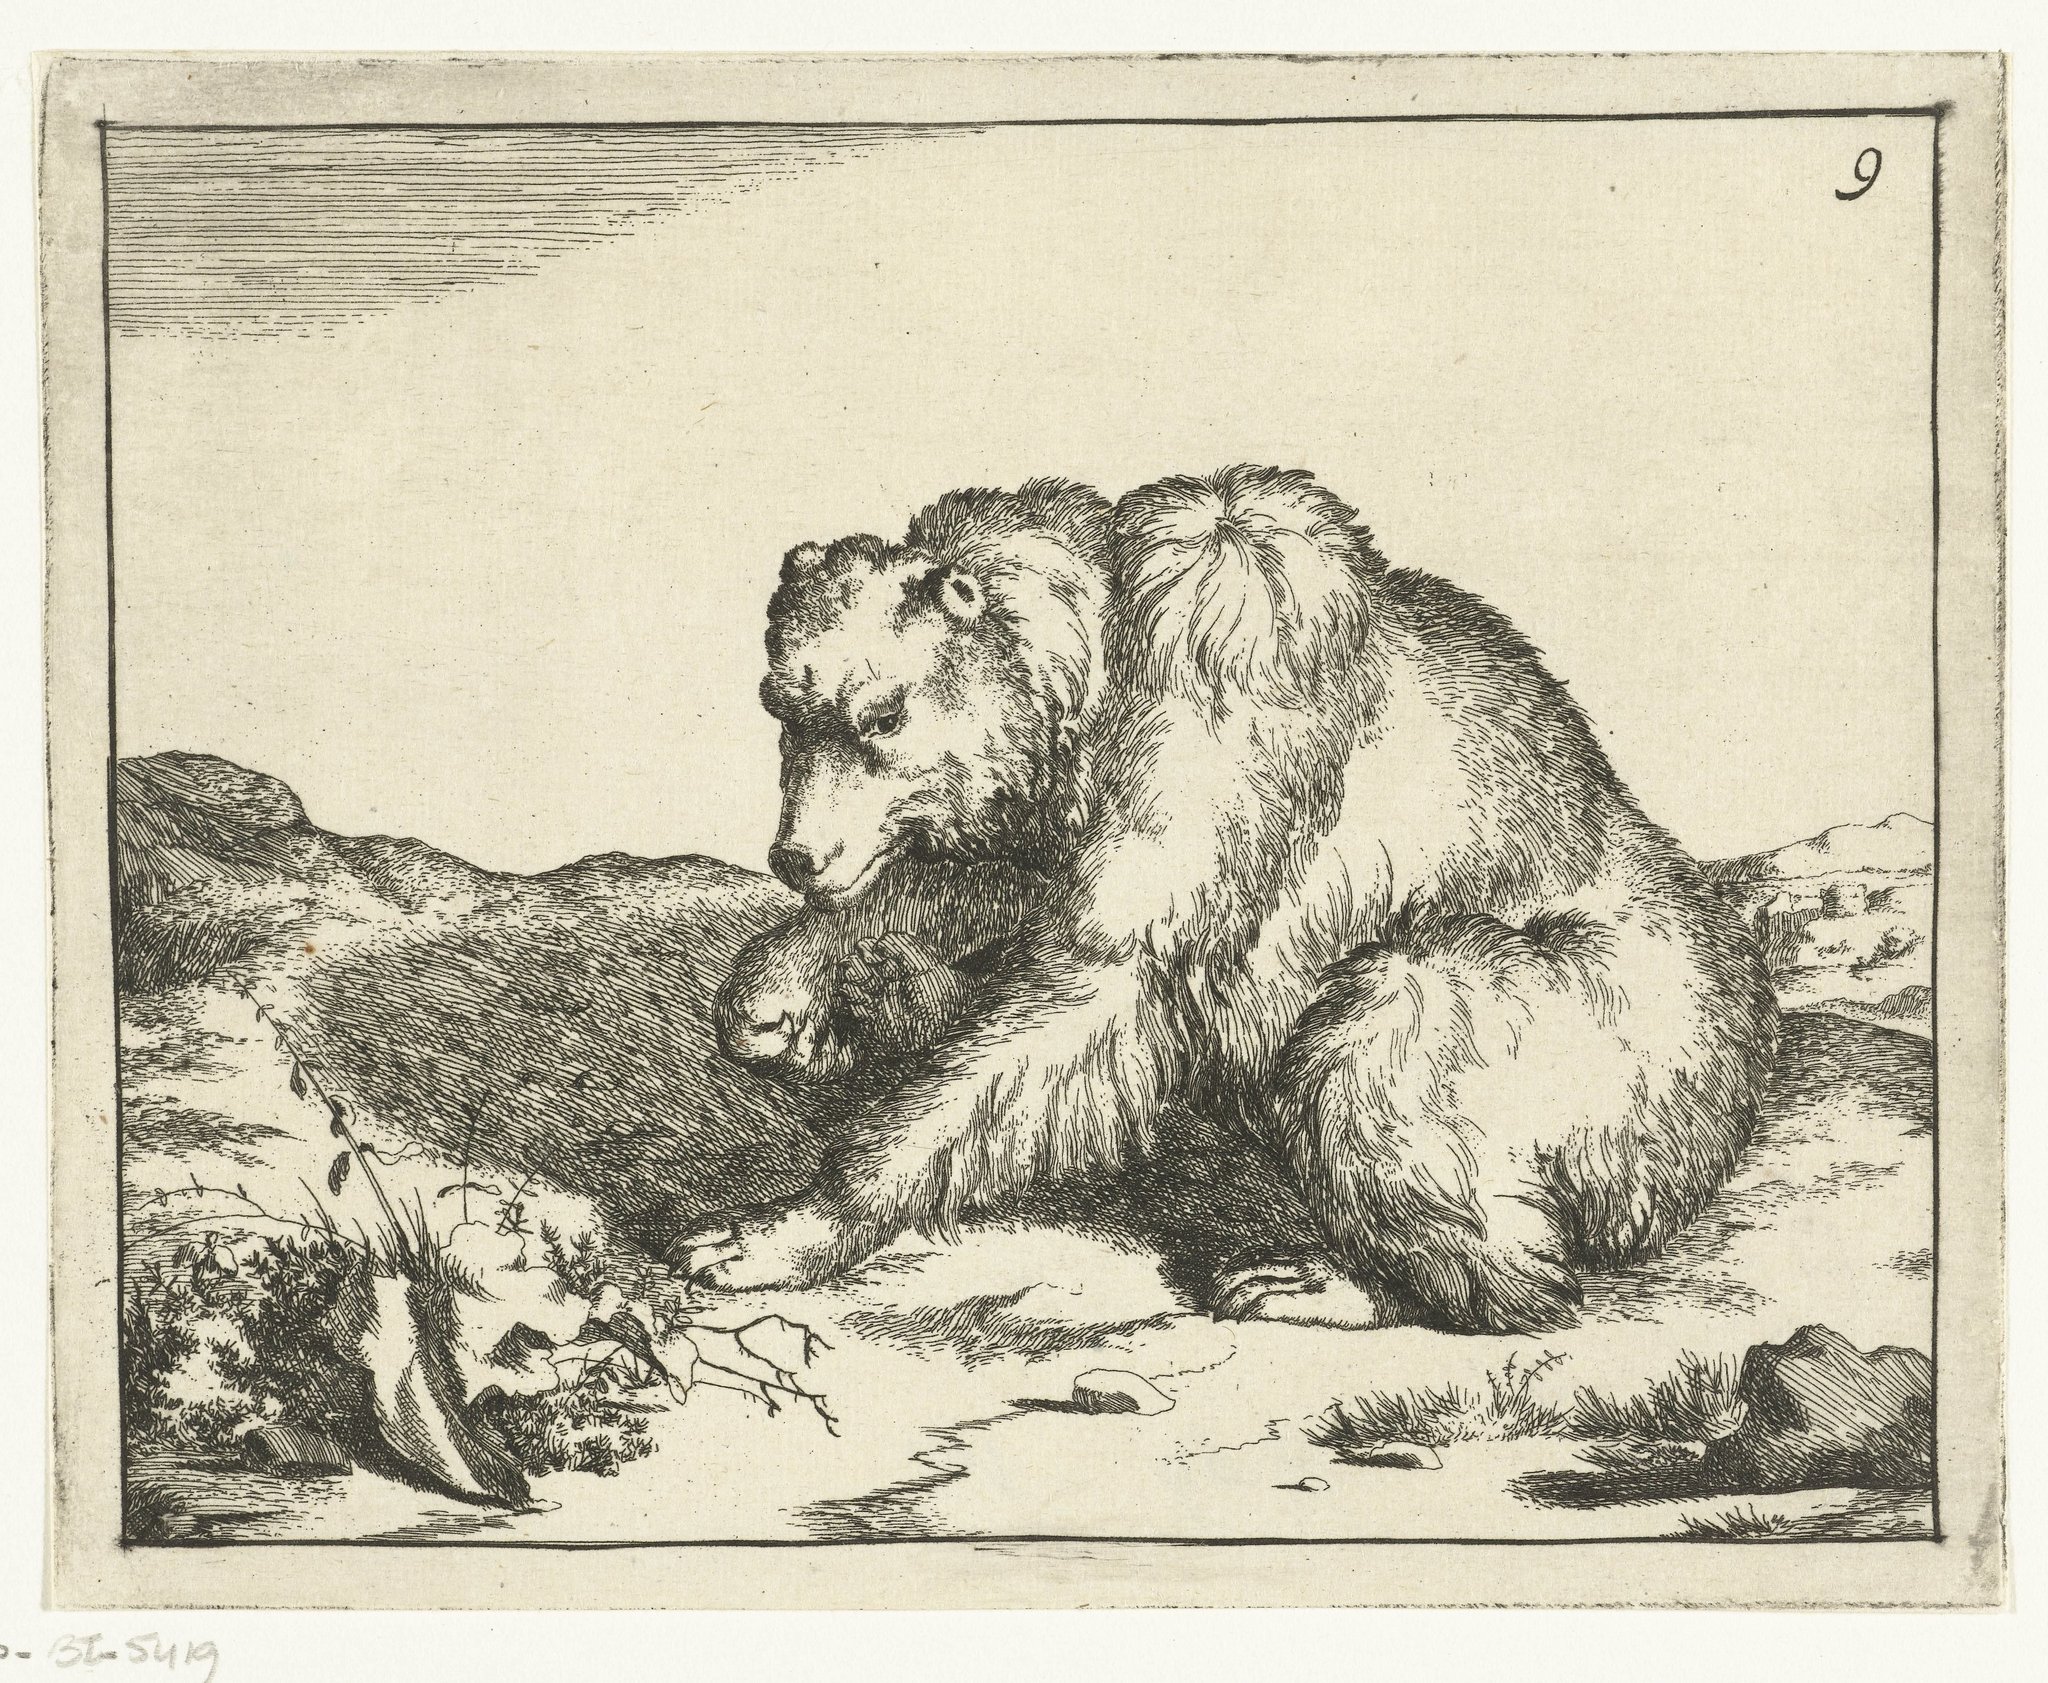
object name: print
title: Beren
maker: marcus de bye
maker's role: print maker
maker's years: 1639-1688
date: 1664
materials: paper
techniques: etching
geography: the hague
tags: beasts of prey, predatory animals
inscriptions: collector's mark: Lugt 240